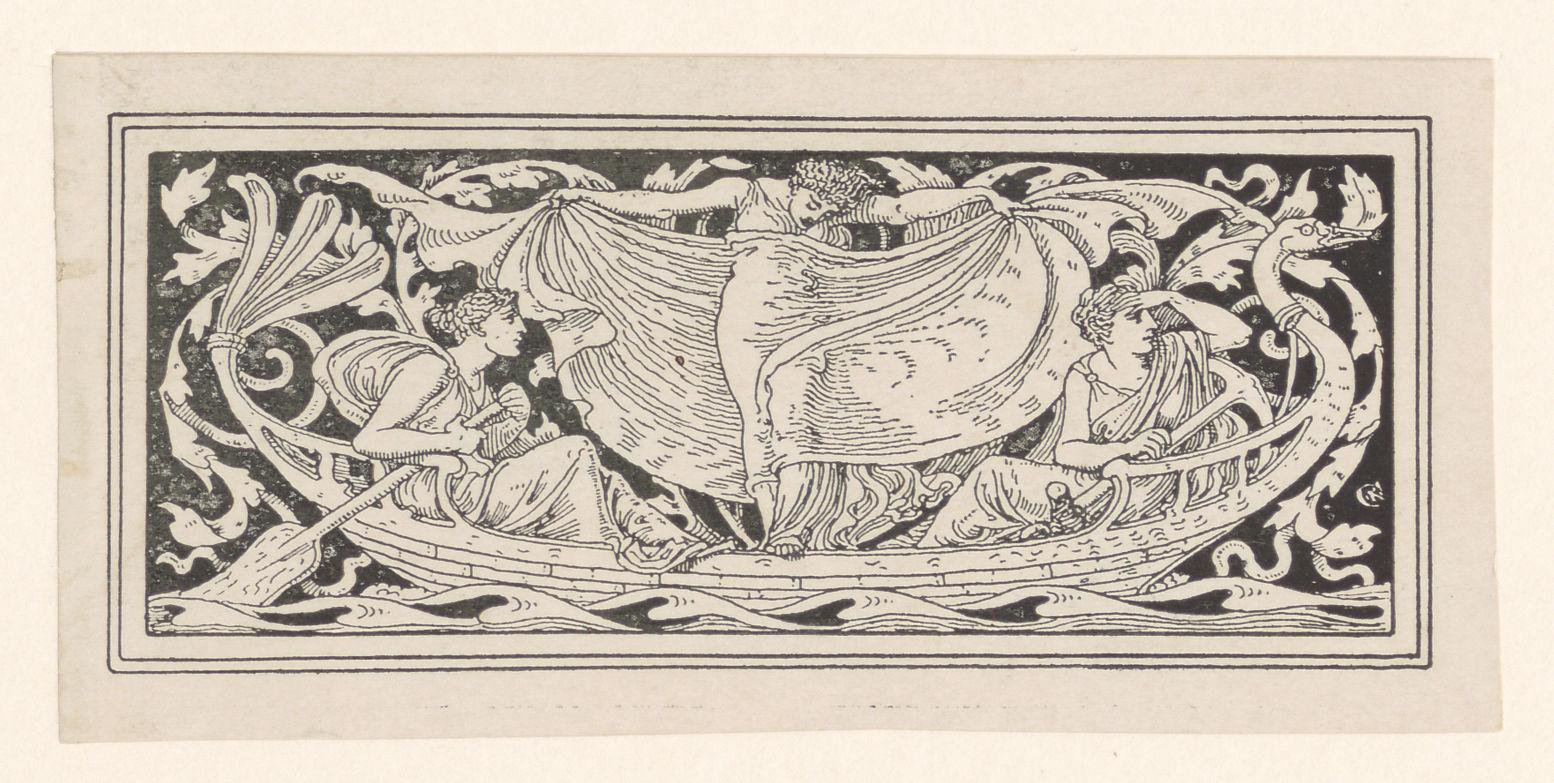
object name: print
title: Drie vrouwen in een roeiboot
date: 1887-1893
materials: paper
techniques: engraving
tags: rowing-boat, canoe, etc., adult woman (+ three persons)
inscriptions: collector's mark: Lugt 2228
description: De prent is gebruikt in: Crane, Walter. The claims of decorative art. Londen: Lawrence & Bullen, 1892.